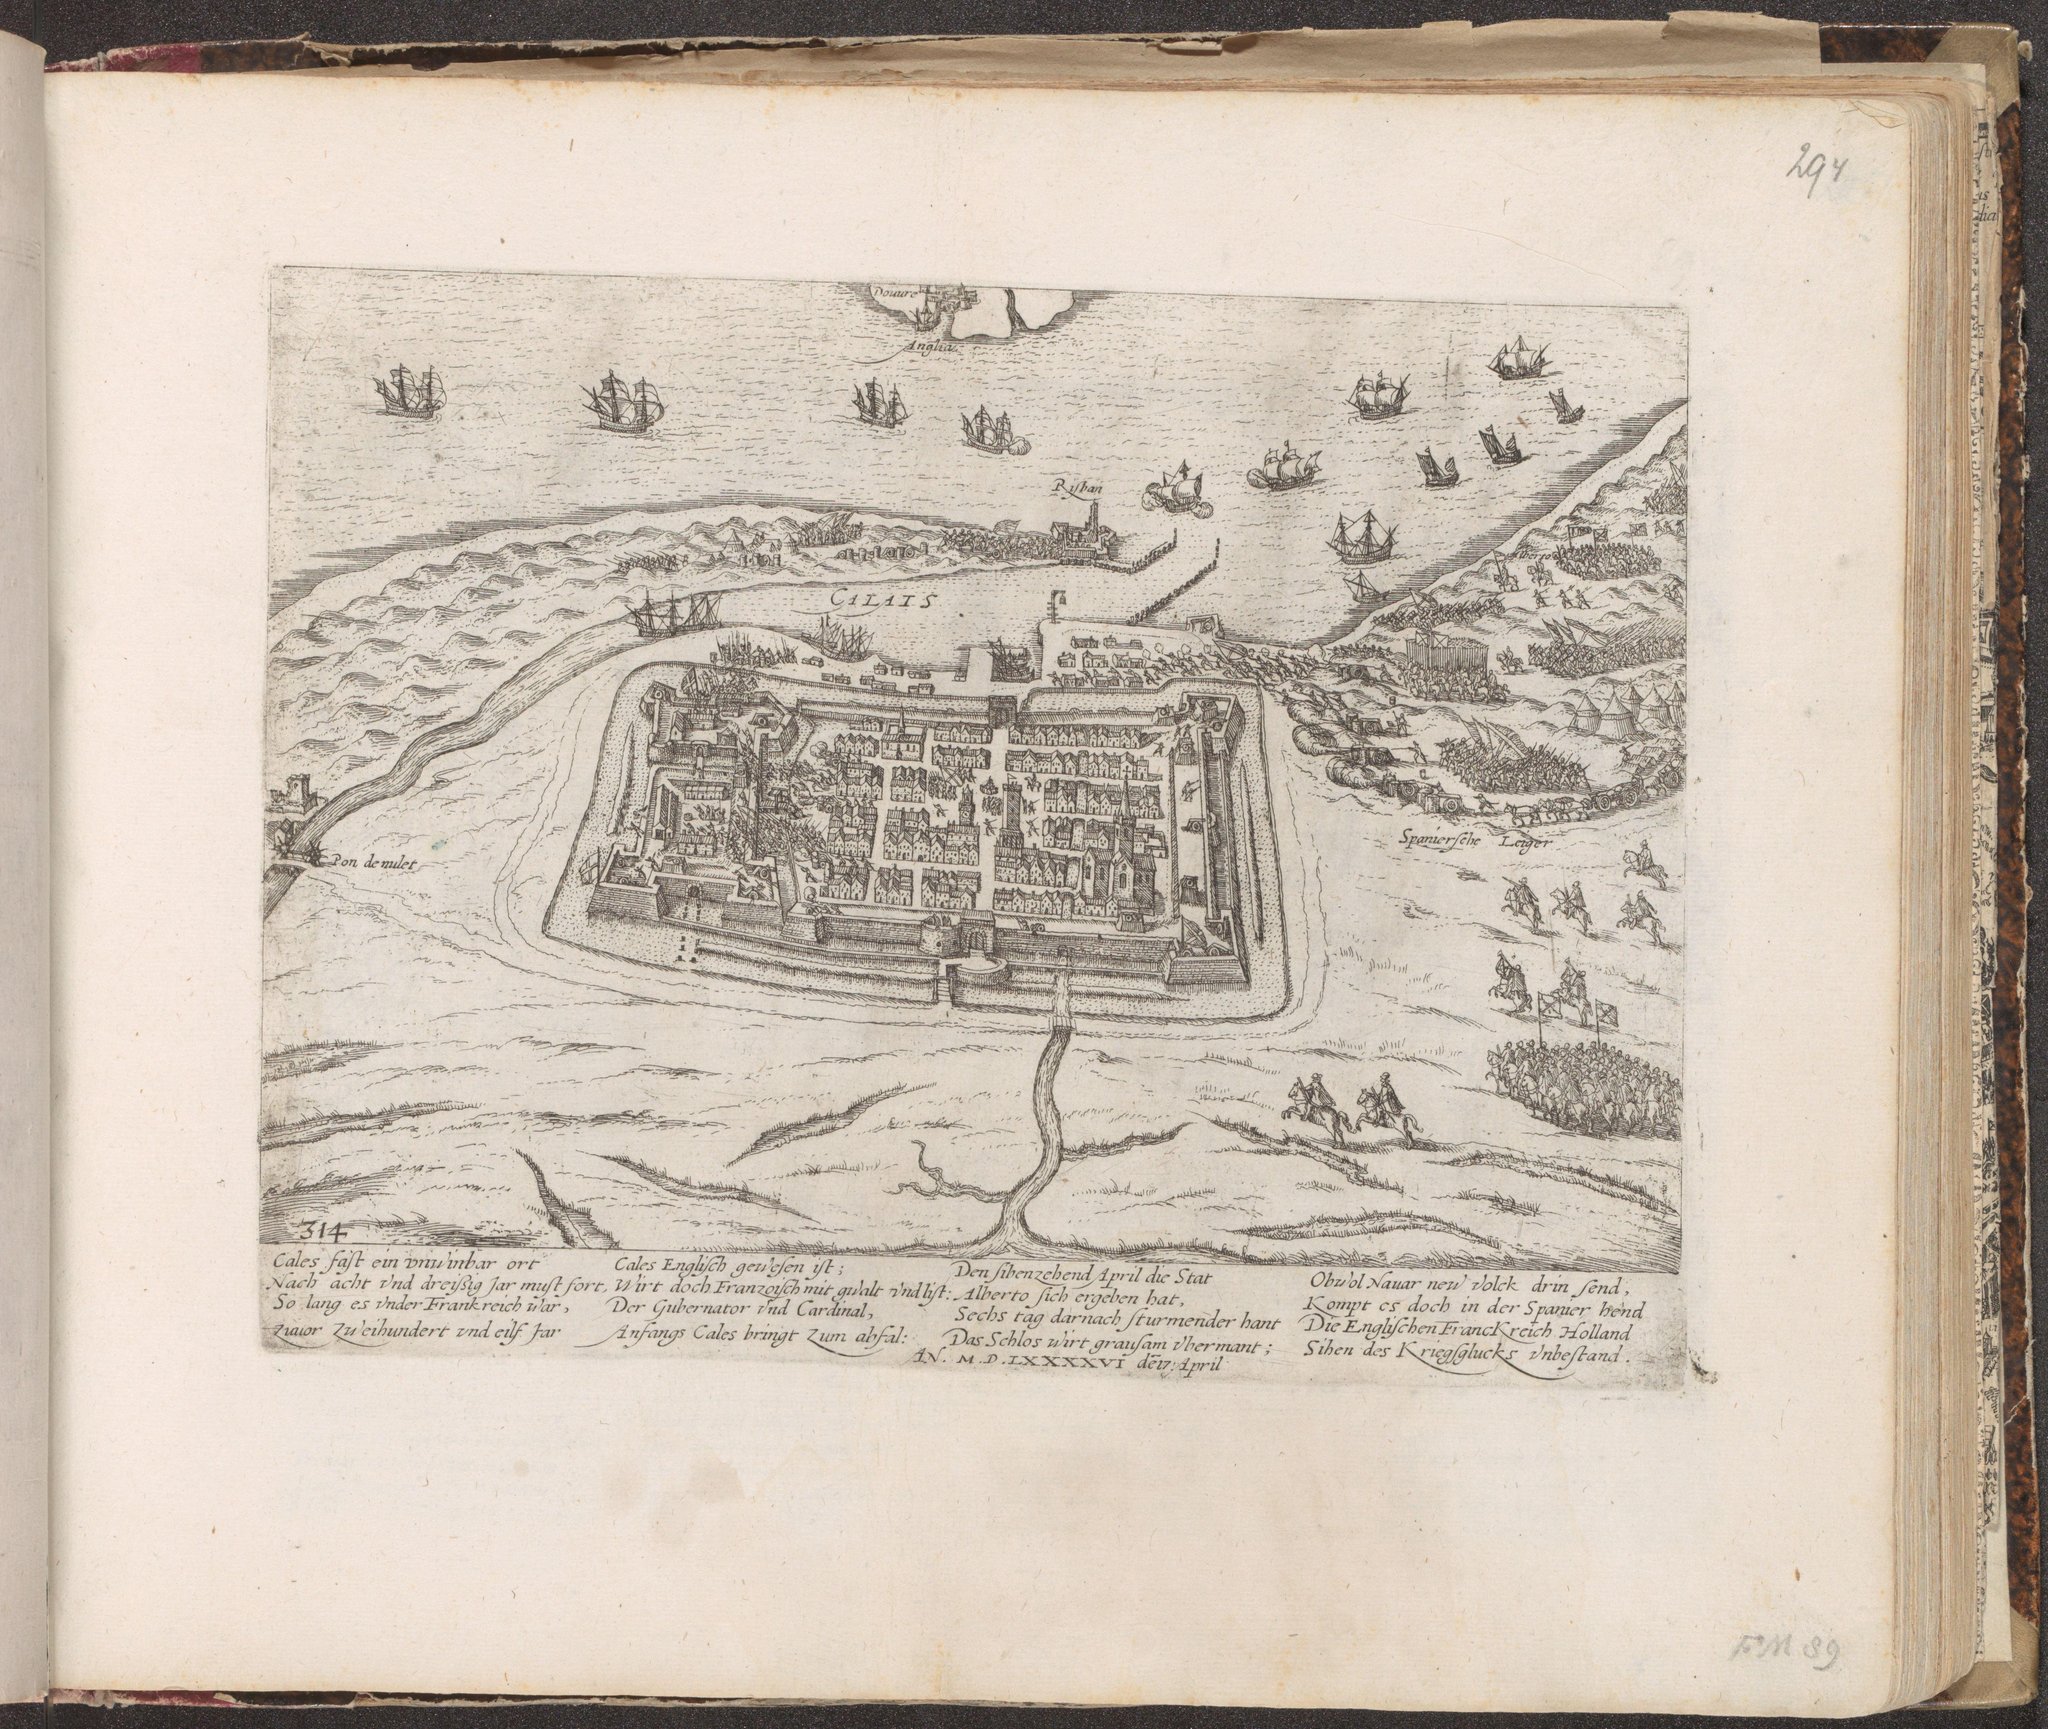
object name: print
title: Serie 4: Franse, Duitse en Engelse Gebeurtenissen, 1576-1610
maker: frans hogenberg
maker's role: print maker, publisher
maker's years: 1538-1590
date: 1596-1598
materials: paper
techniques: etching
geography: cologne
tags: brussels, albrecht aartshertog van oostenrijk, capture of city (after the siege)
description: Inname van Calais door Albrecht, 17 april 1596. Van rechts trekt het Spaanse leger op in de richting van Calais. Met onderschrift van 16 regels in het Duits. Linksonder genummerd: 314. De prent maakt deel uit van een album.